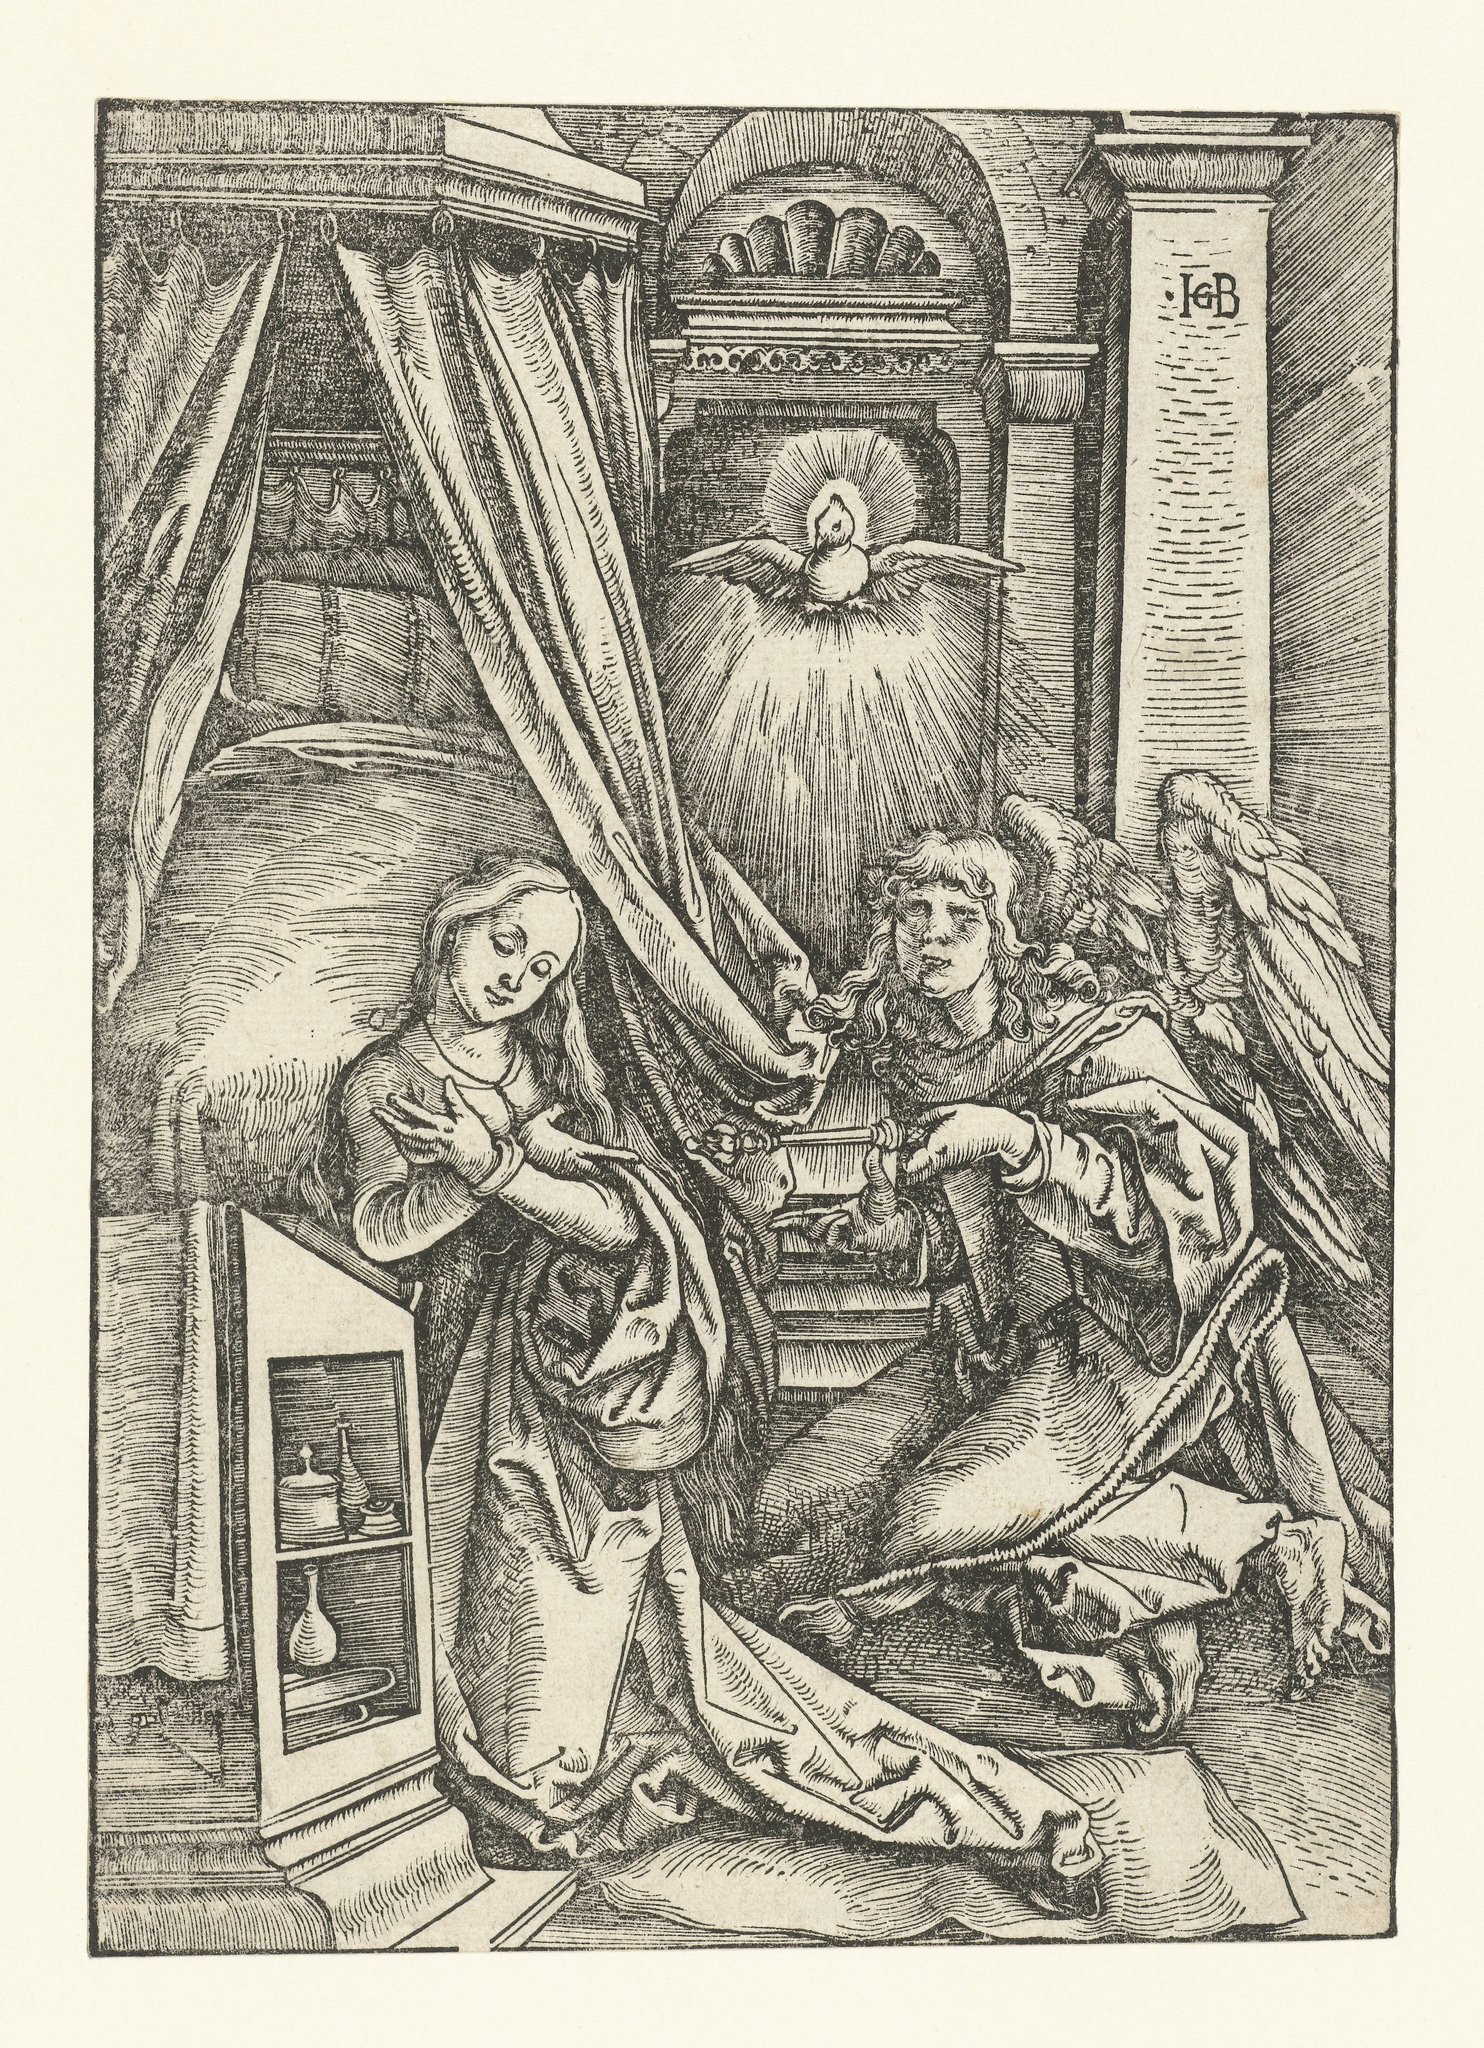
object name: print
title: Annunciatie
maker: hans baldung grien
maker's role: draughtsman, print maker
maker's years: 1484-1545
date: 1512-1516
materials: paper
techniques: woodcut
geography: freiburg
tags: the annunciation: mary kneeling - aa - mary to the left, the angel to the right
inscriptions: collector's mark: Lugt 2760, collector's mark: Lugt 2228a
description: Maria knielt in gebed bij een lessenaar in haar slaapvertrek. De Engel Gabriël knielt naast haar en wijst met een scepter, met op de knop een lelie, naar haar. Met zijn hand maakt hij een spreekgebaar. Boven hen is een duif weergegeven als symbool voor de Heilige Geest in een stralenkrans.